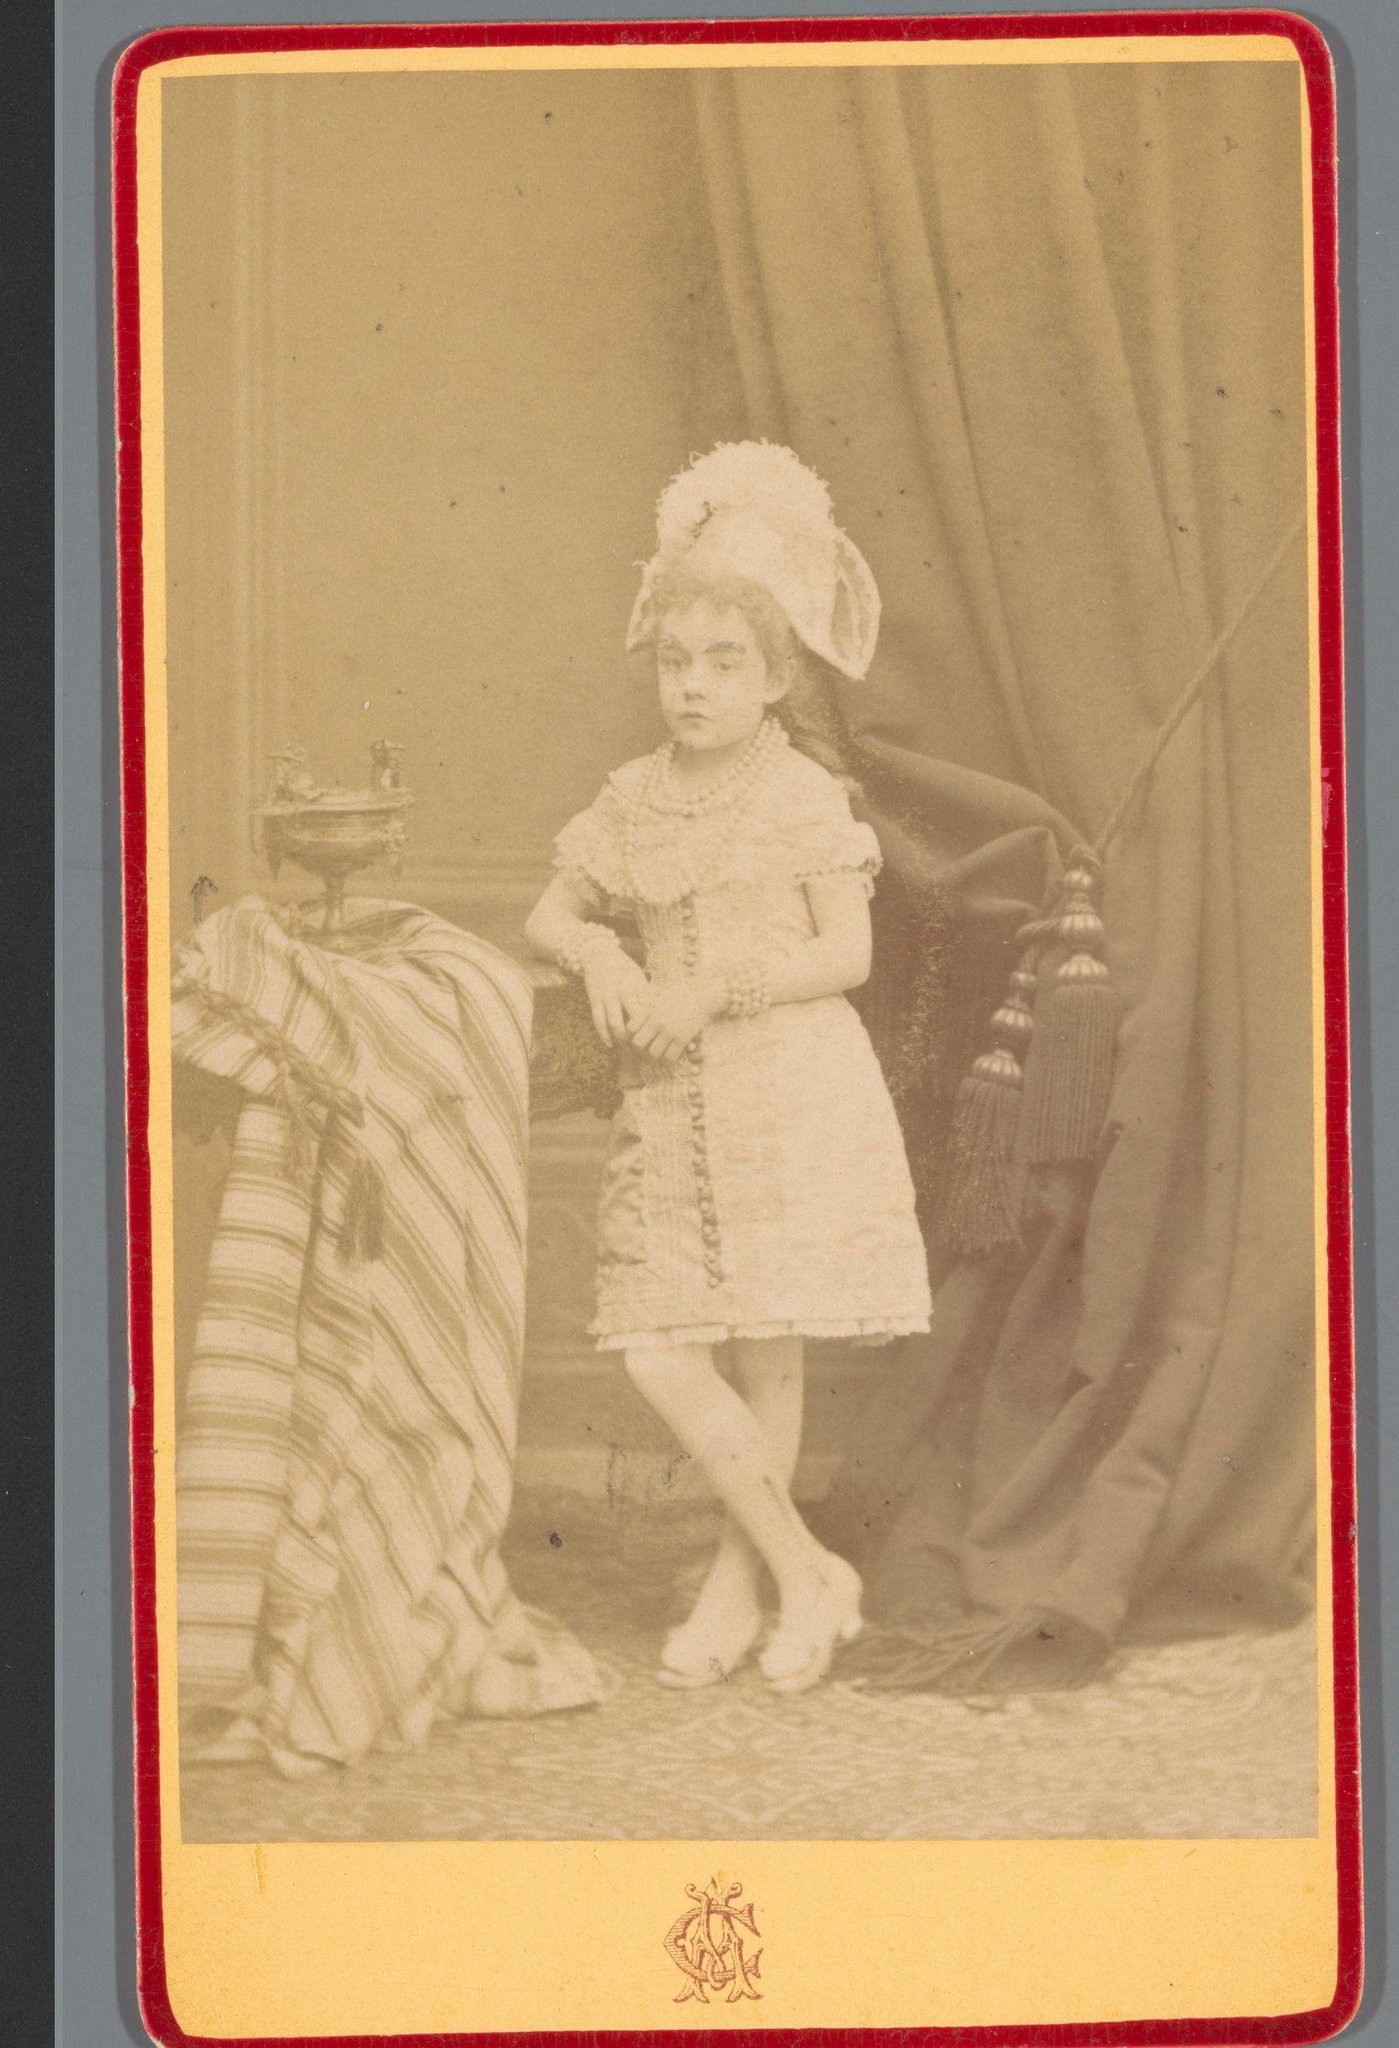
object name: photograph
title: Portret van een onbekend meisje met een hoed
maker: angelo maria alessio caccia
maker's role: fotograaf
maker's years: 1802-1877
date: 1868-1890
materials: cardboard, paper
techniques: albumen print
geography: le havre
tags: girl (child between toddler and youth), anonymous historical person portrayed, le havre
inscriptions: inscription: ‘Art & Photographie/ A. Caccia/ Havre/ 126/ Boulevard de Strasbourg/ Paris/ 120/ Rue St. Lazare/ Les Clichés sont conservés.’, monogram: ‘AC’